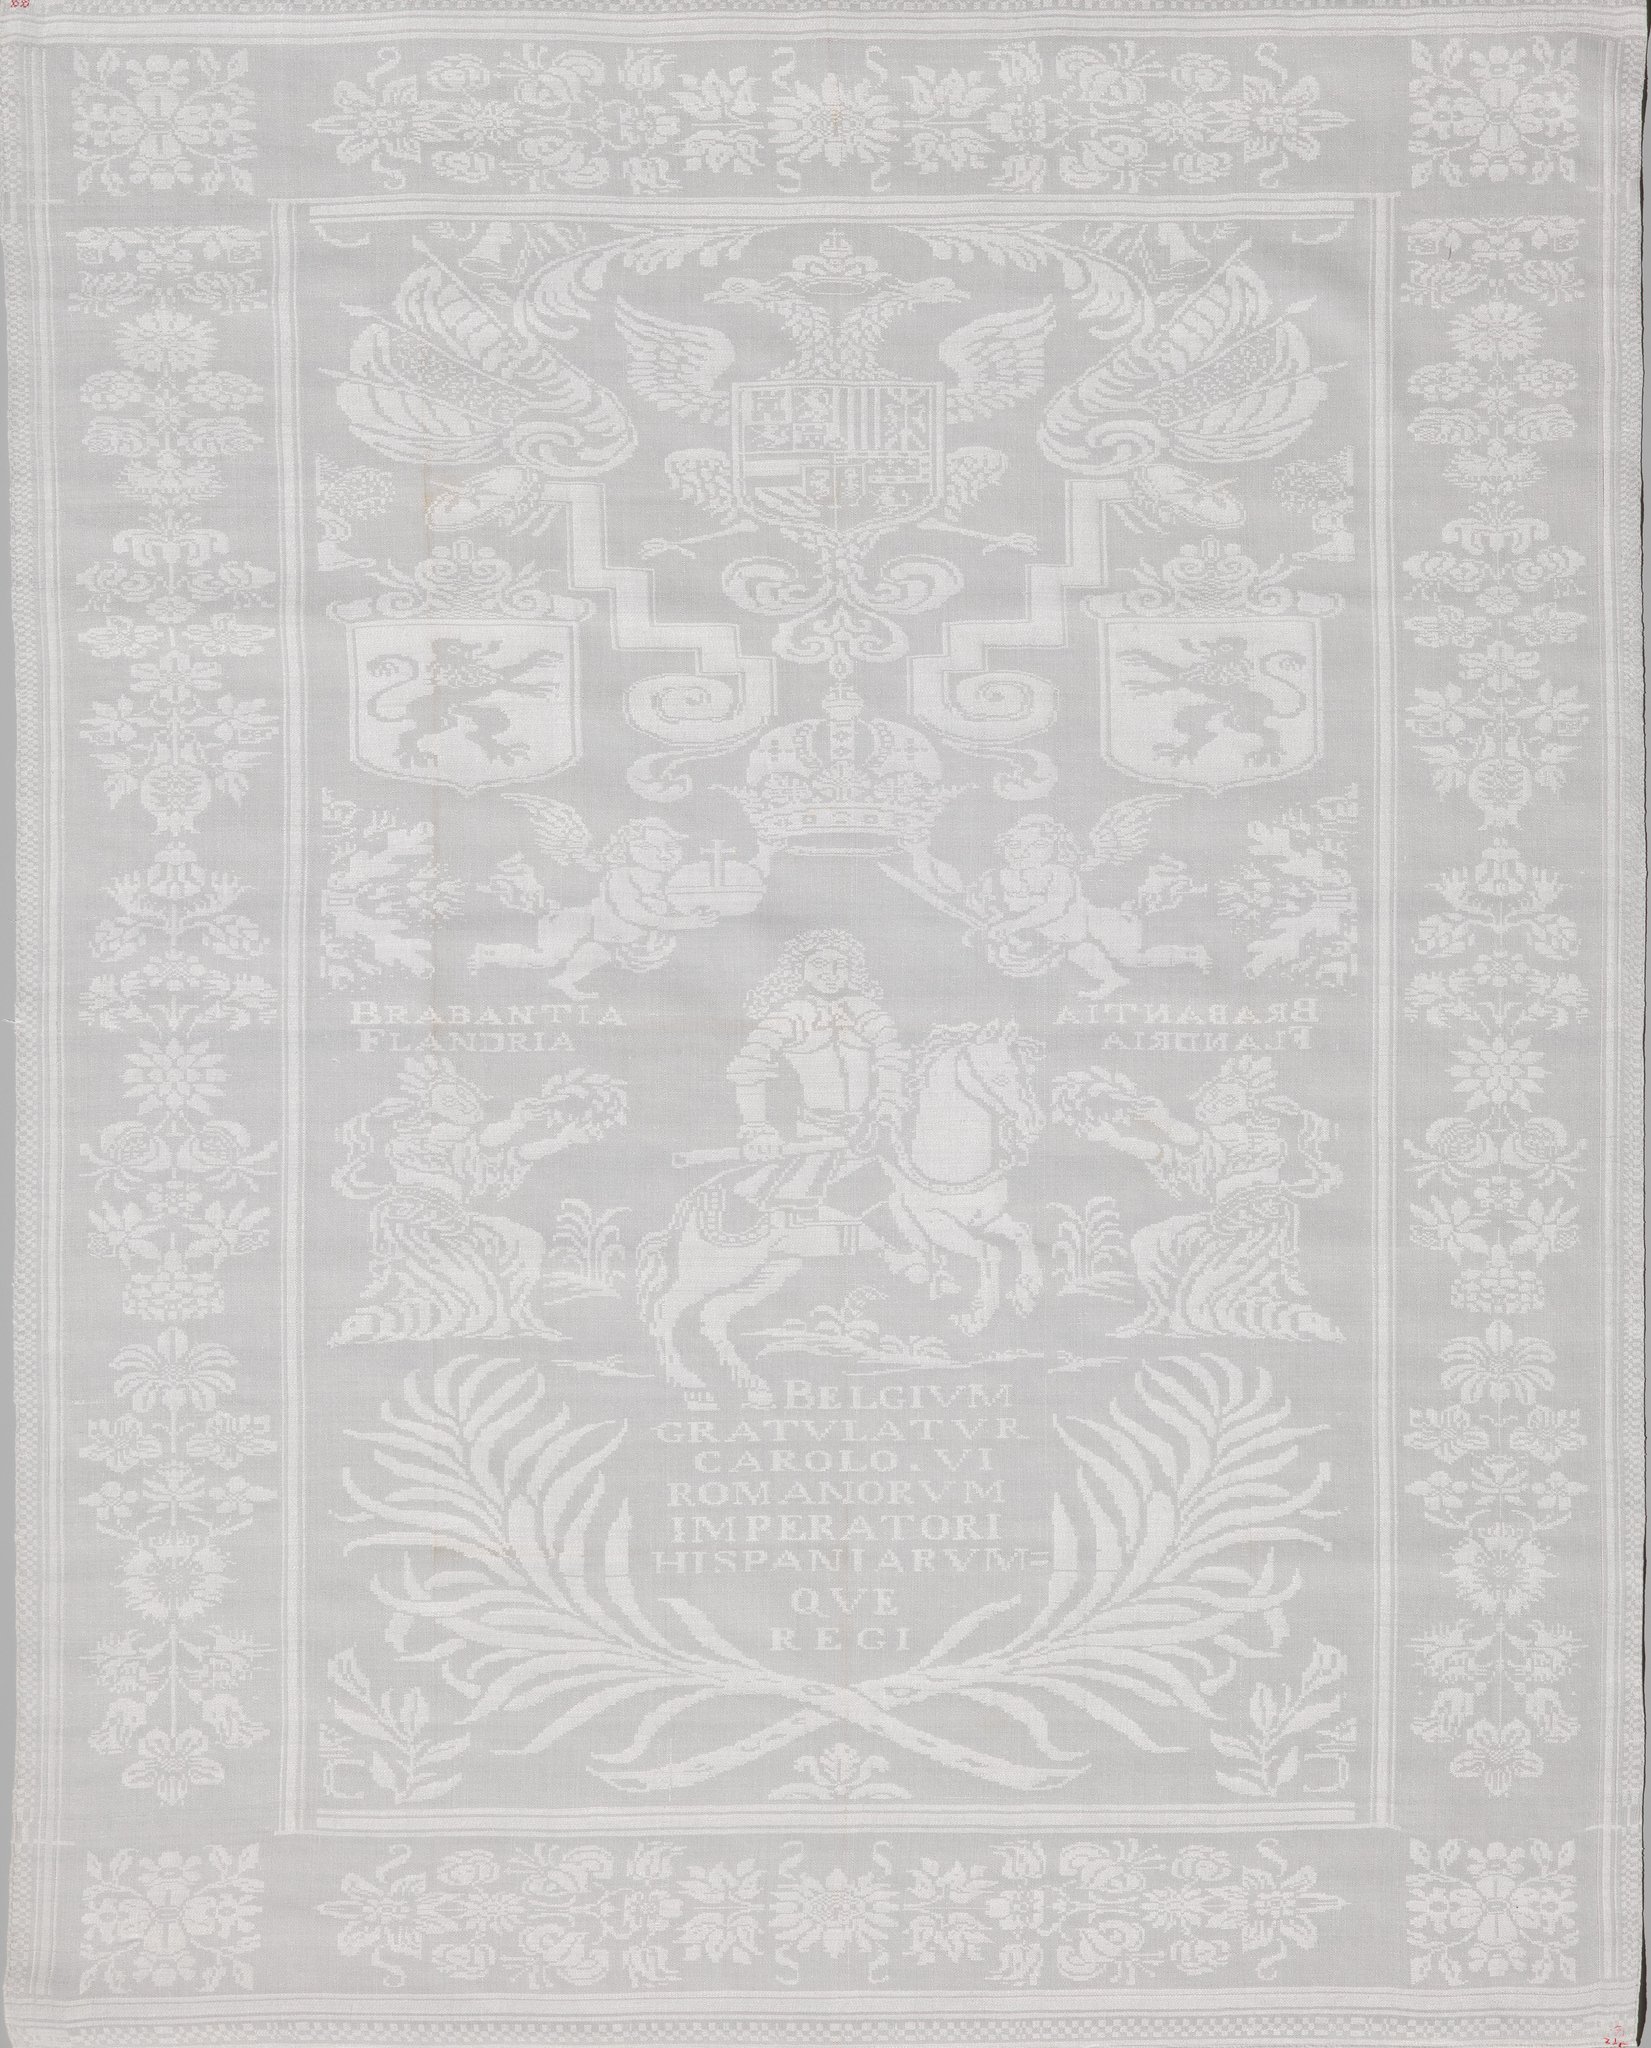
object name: napkin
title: Servet van linnendamast met de verheerlijking van Karel VI van Habsburg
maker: Anonymous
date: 1711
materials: linen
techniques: damask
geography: flanders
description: Wit linnendamasten servet met de verheerlijking van Karel VI van Habsburg. Rode borduursteek: BB en in rood gestikt 21.